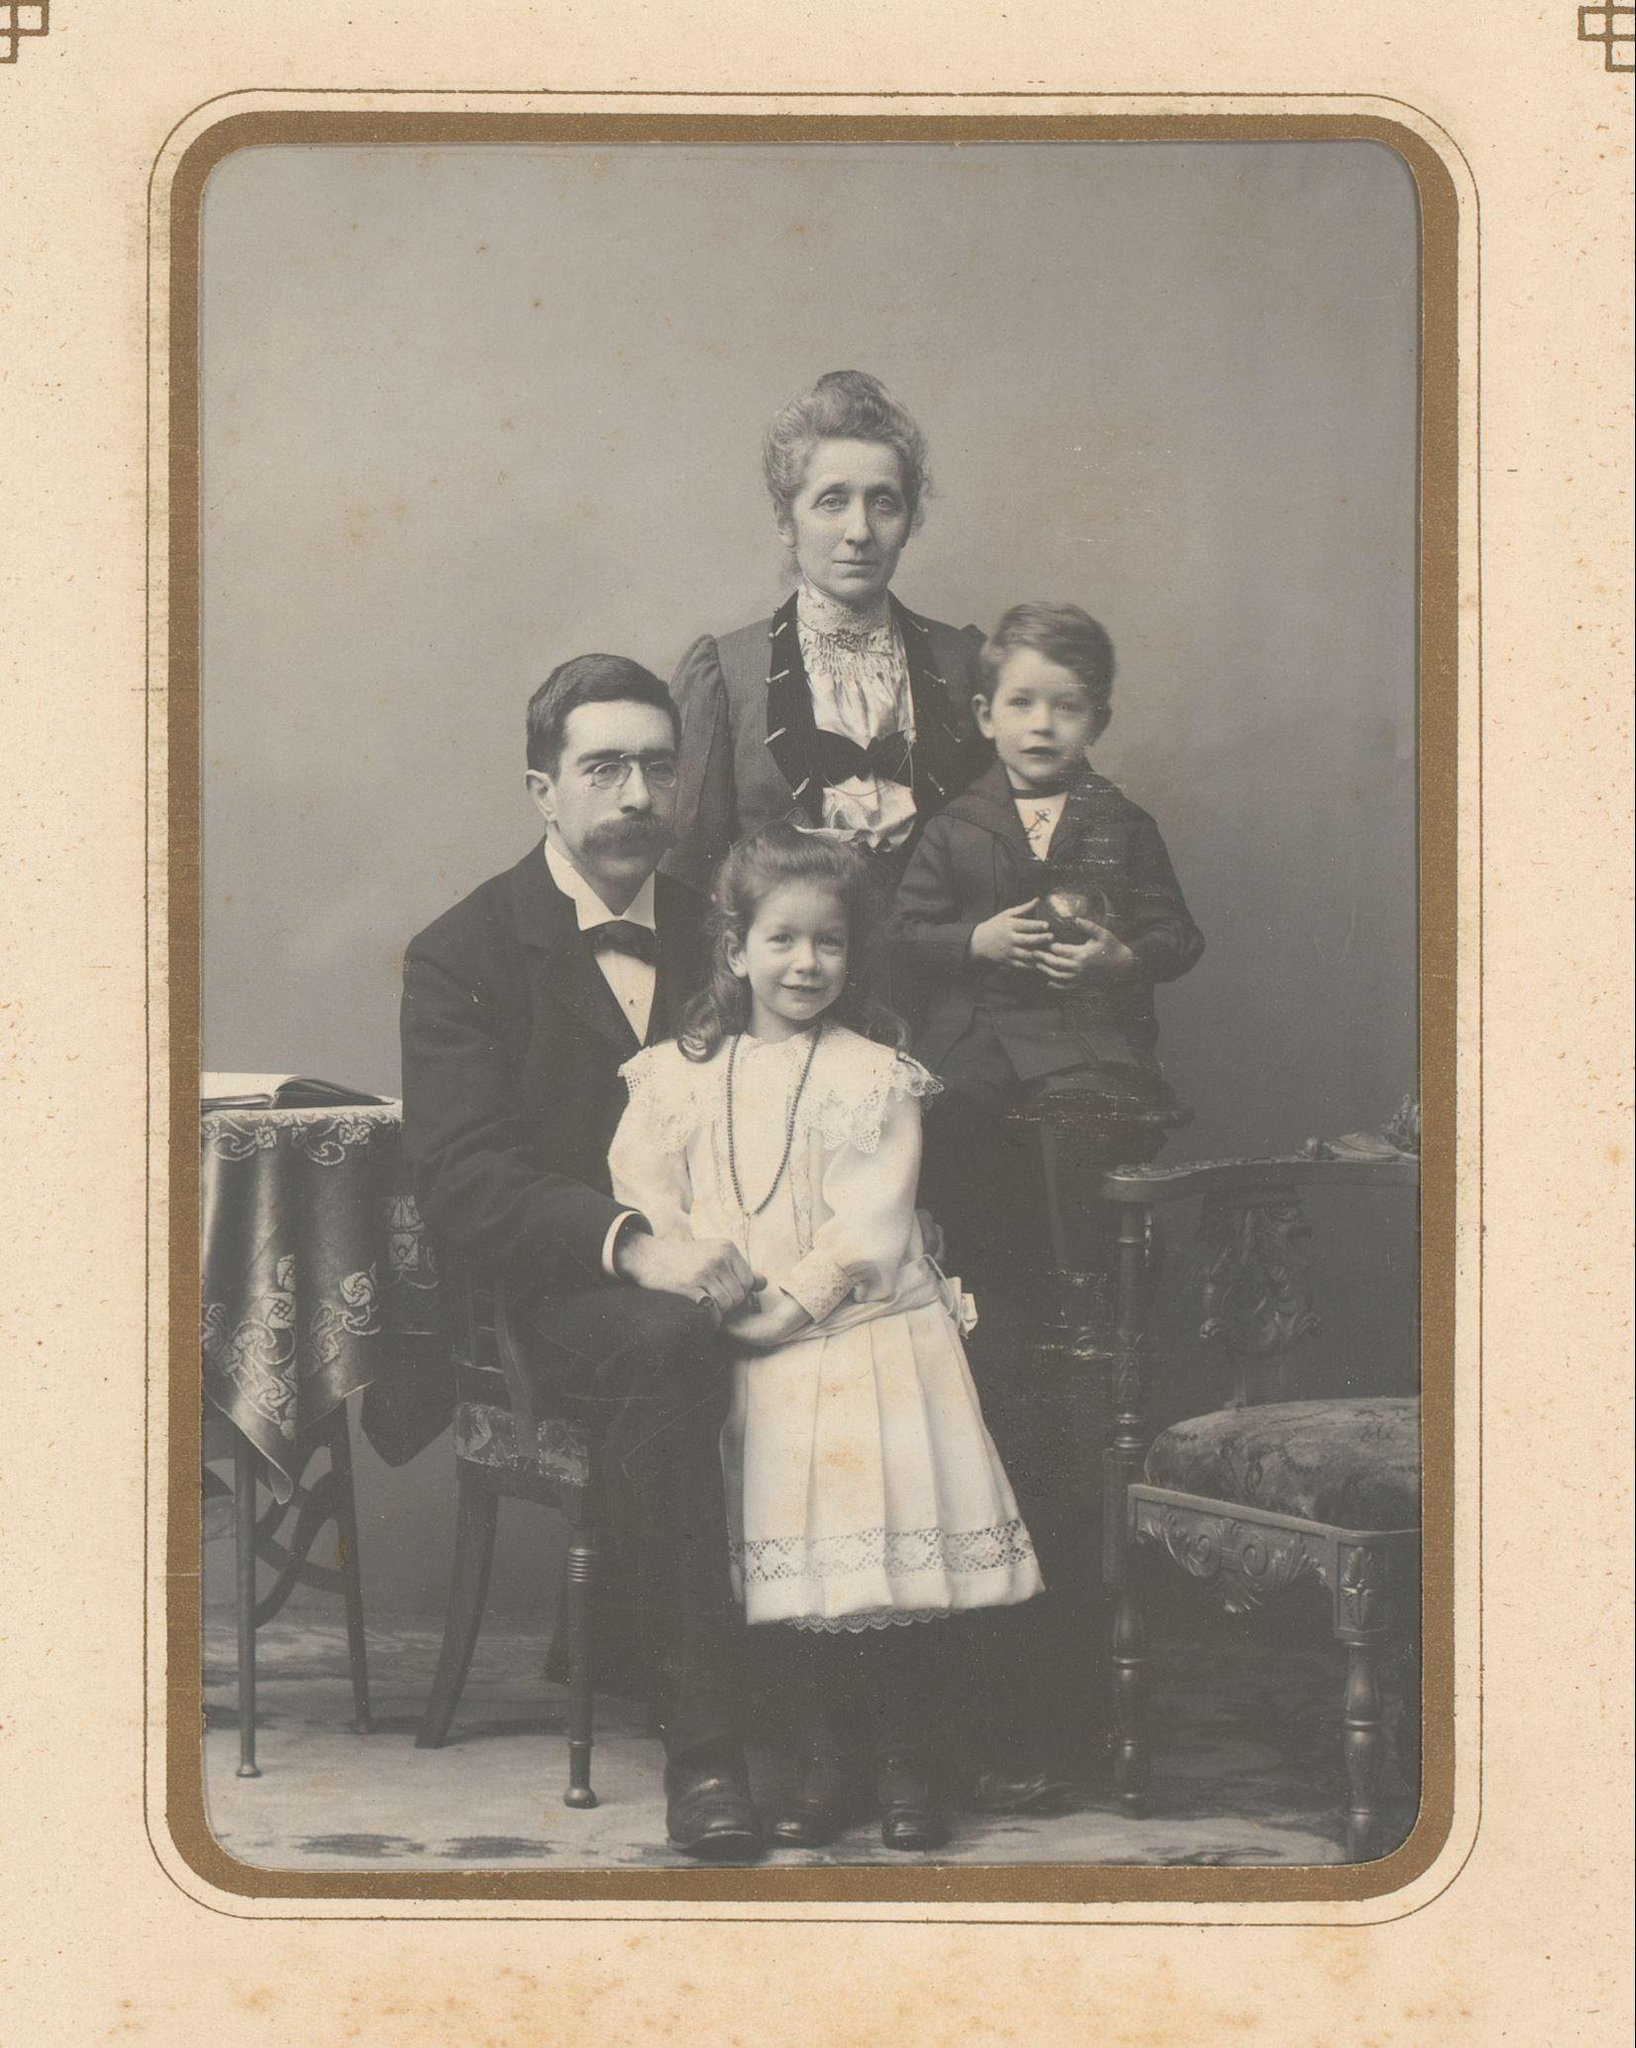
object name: album leaf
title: Familieportret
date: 1880-1920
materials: cardboard, photographic support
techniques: collodion silver print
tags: eyeglasses, spectacles, parents with their children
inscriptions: inscription: ‘Fototgrafische Ateliers/ Jac & J. Schotel Szn/Erasmusstraat 3/ Schiedamsche Singel 56/ Rotterdam/ (...)’